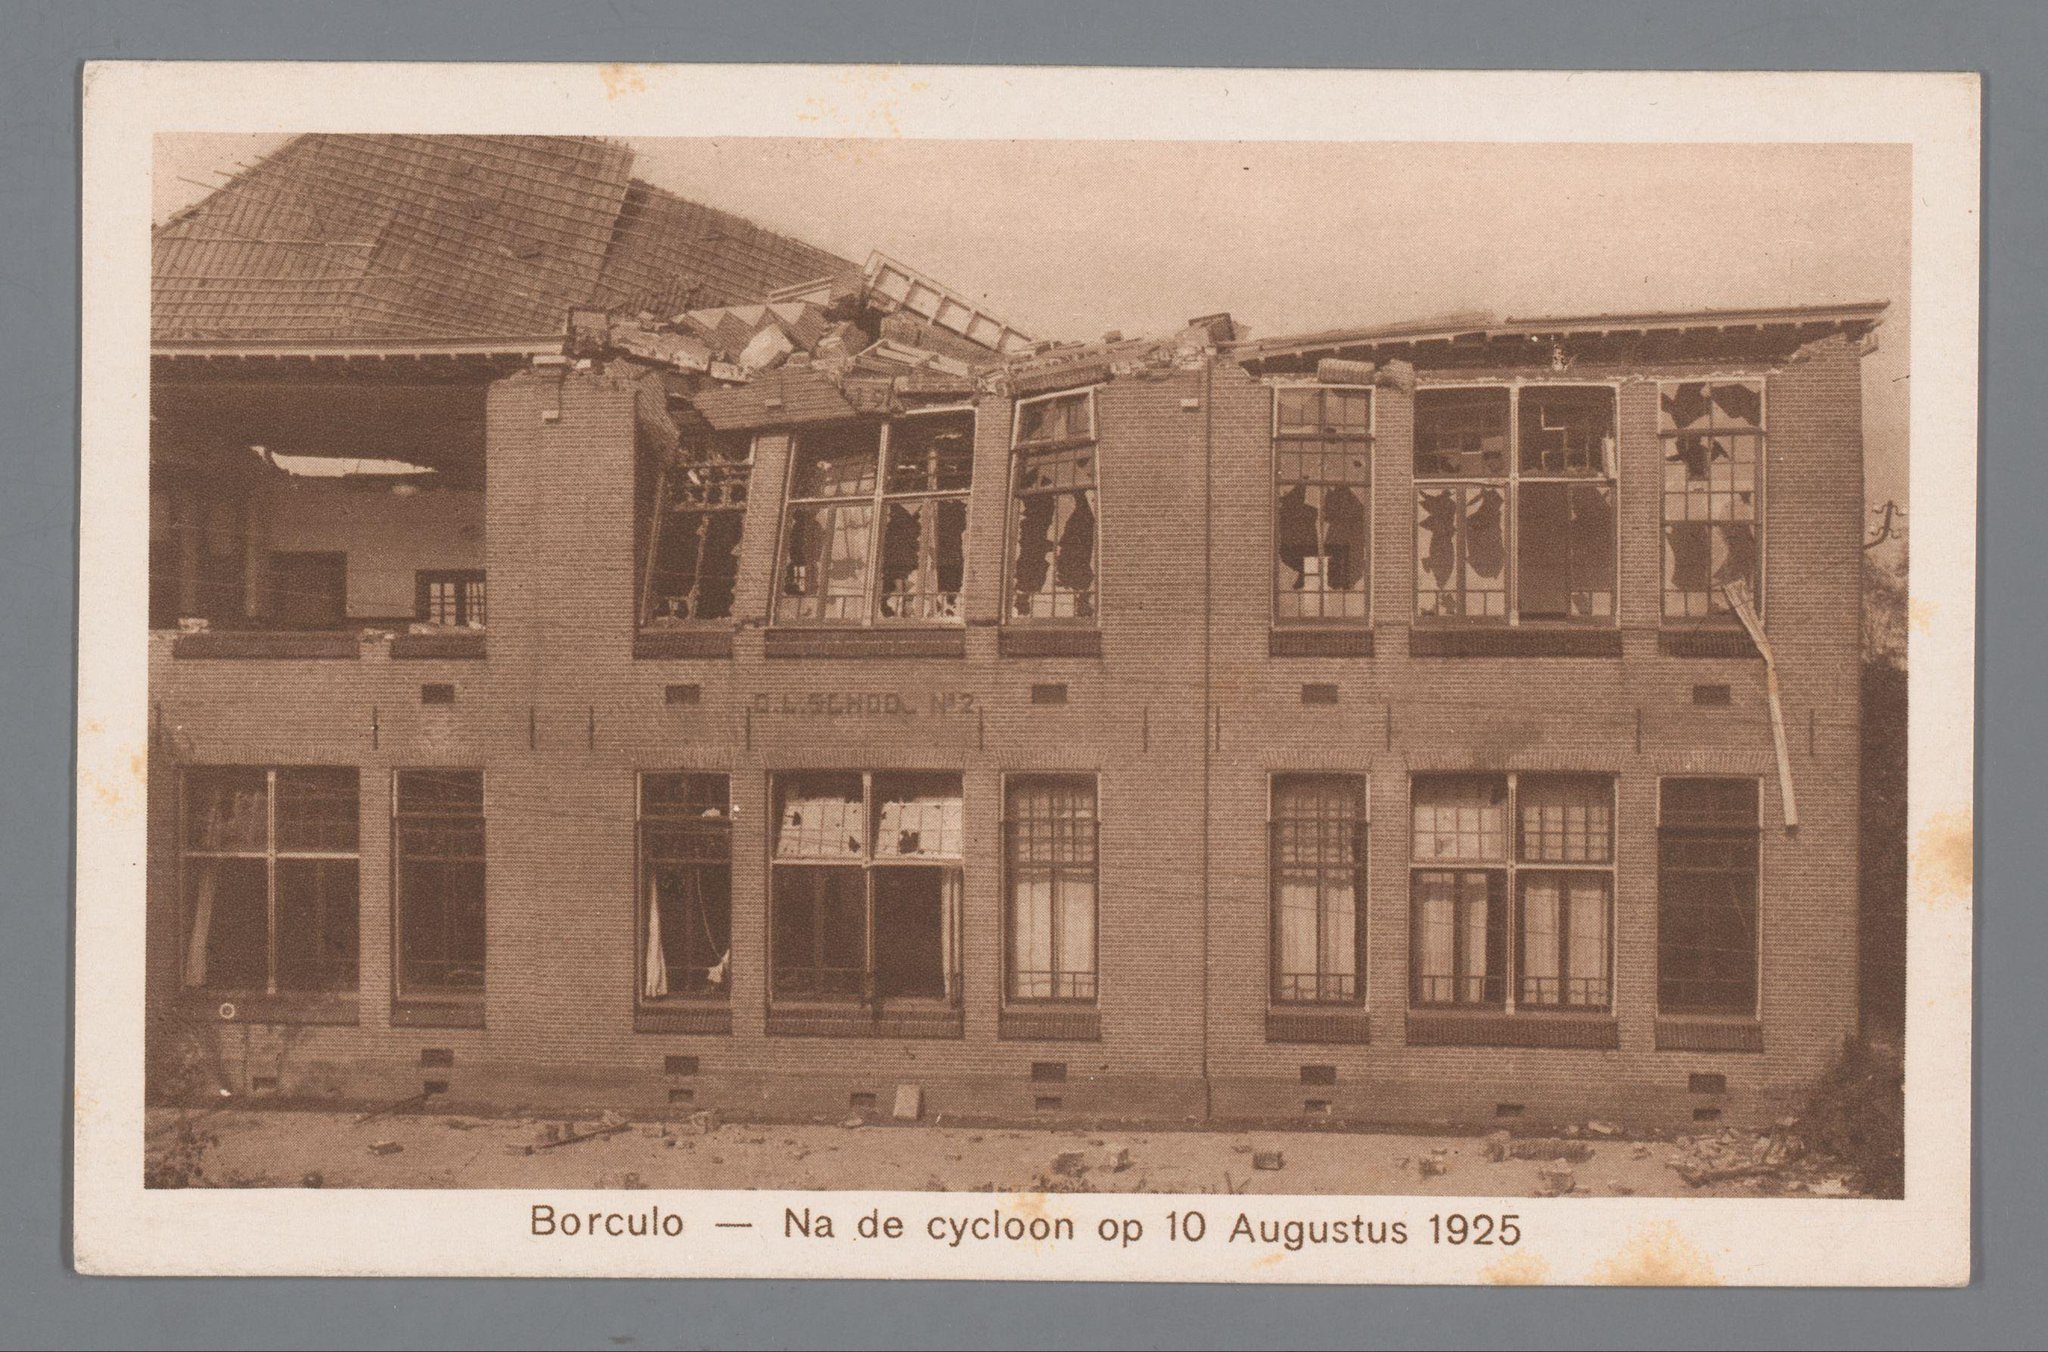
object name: ansichtkaart, prentbriefkaart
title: Borculo -- Na de cycloon op 10 augustus 1925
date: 1925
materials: paper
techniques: photography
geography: the hague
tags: borculo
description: Briefkaart, bruingetint foto van de toestand in Borculo nadat er op 10-08-1925 een cycloon over het dorp was geraasd.